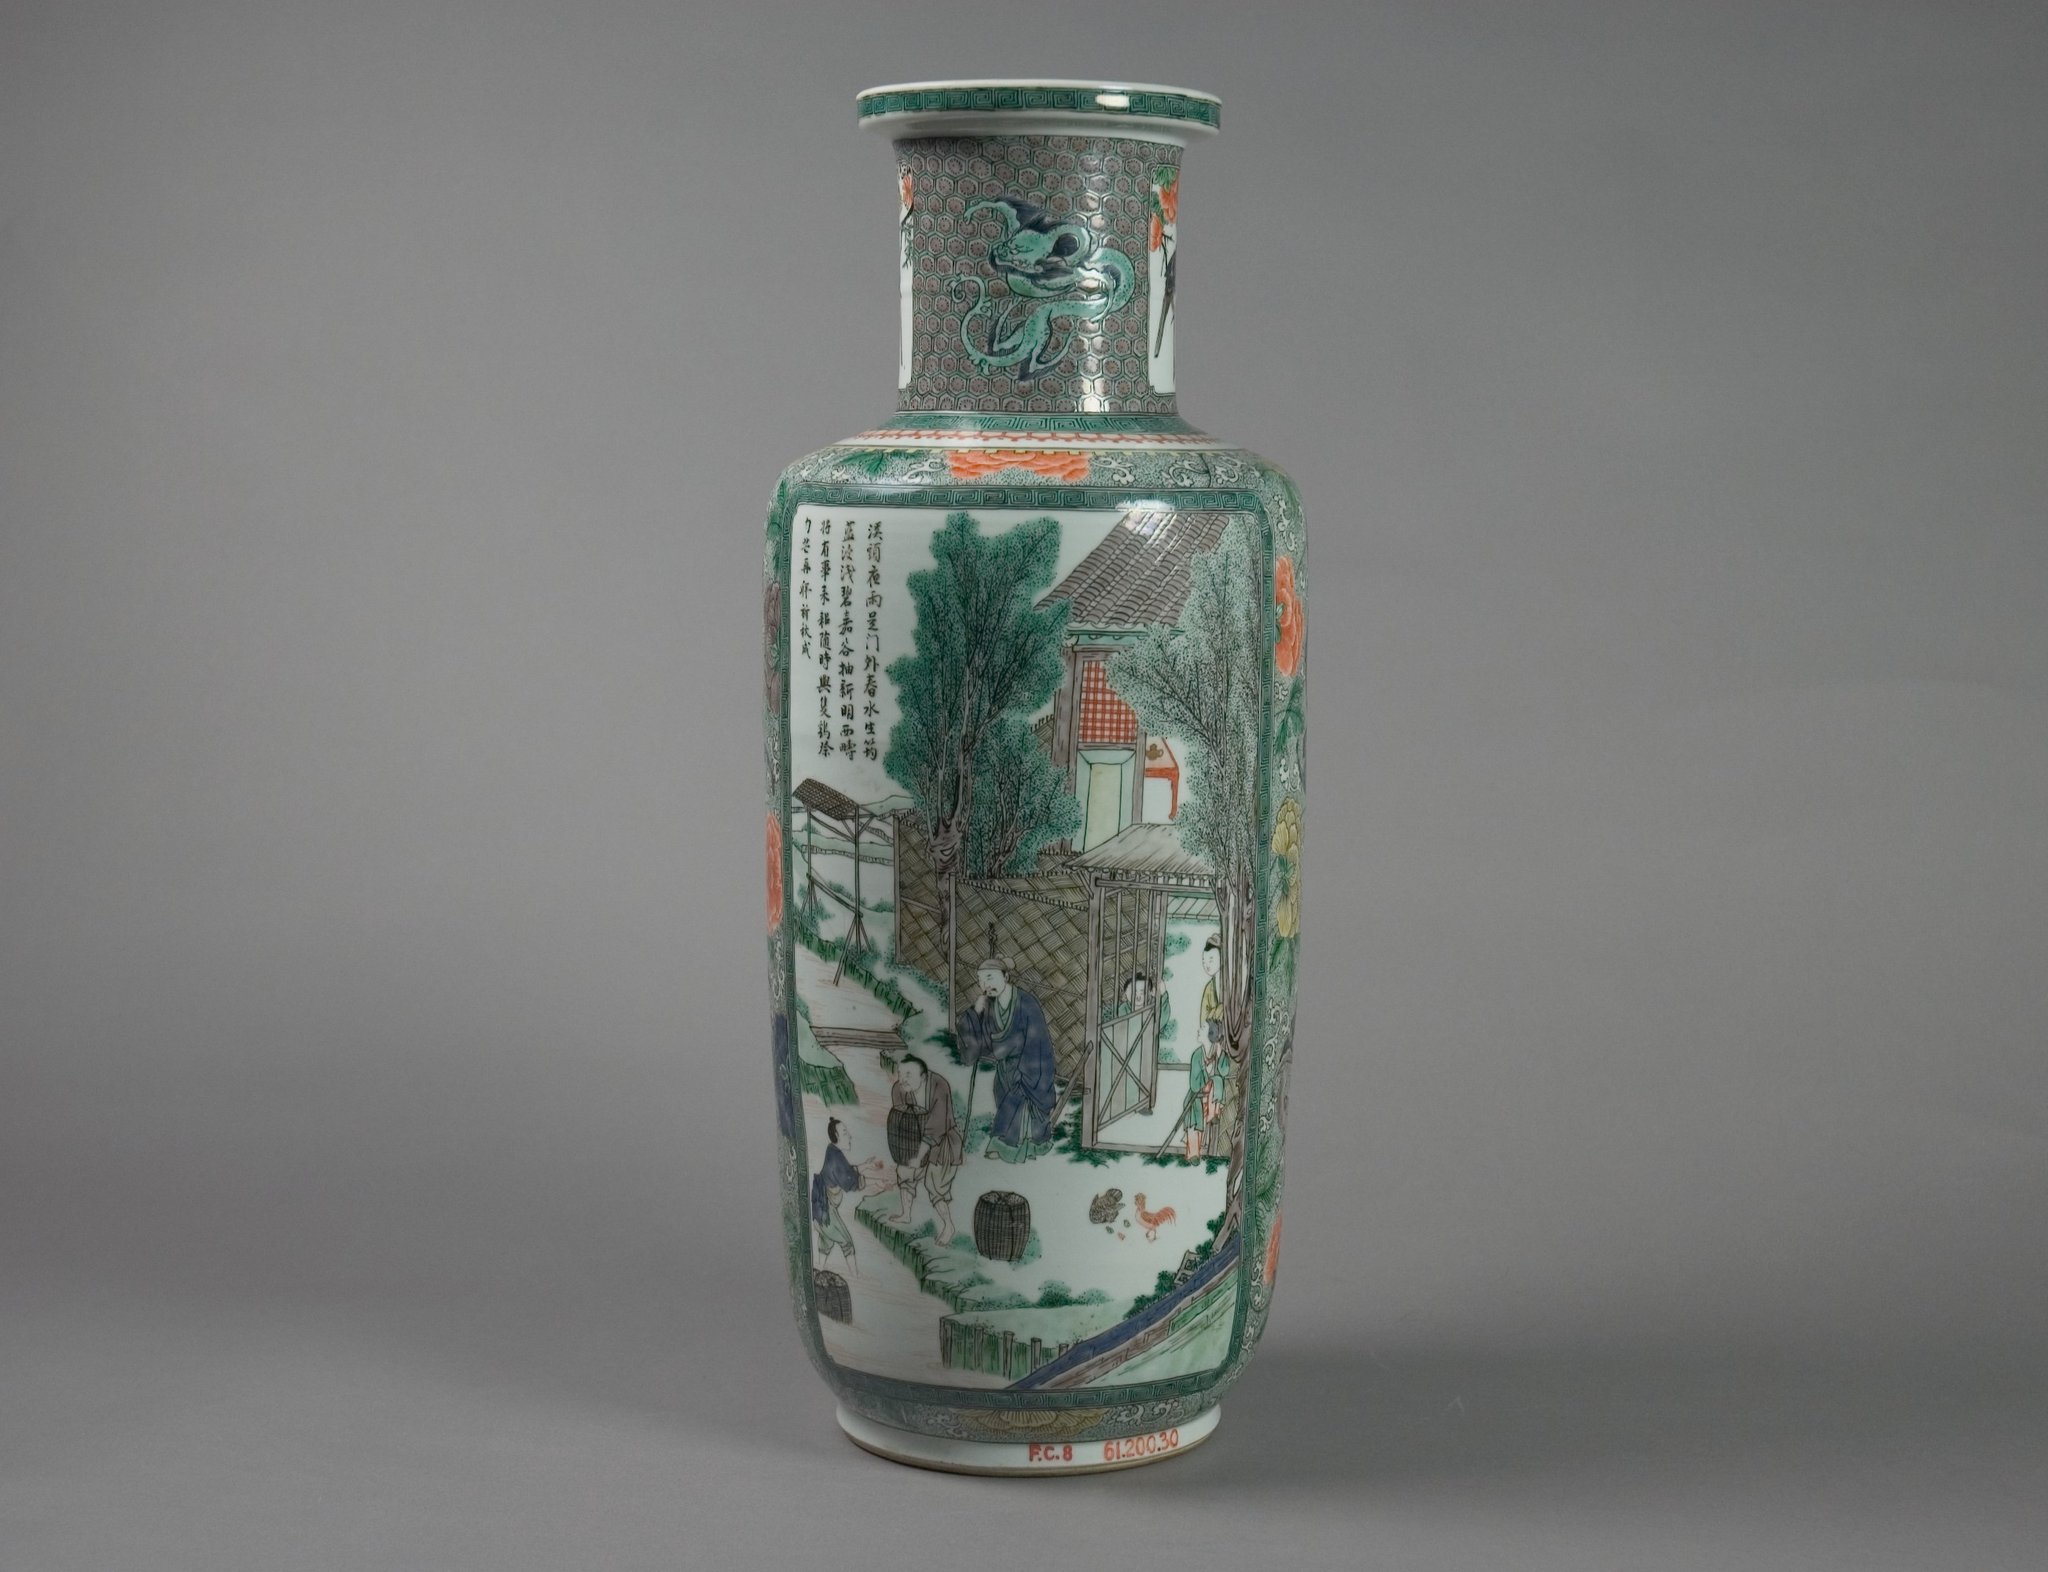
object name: vase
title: Vase with scenes and poems from Farming and Weaving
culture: chinese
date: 1662-1722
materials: enamel, porcelain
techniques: overglaze, painting, polychrome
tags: farms,men,women,dragons